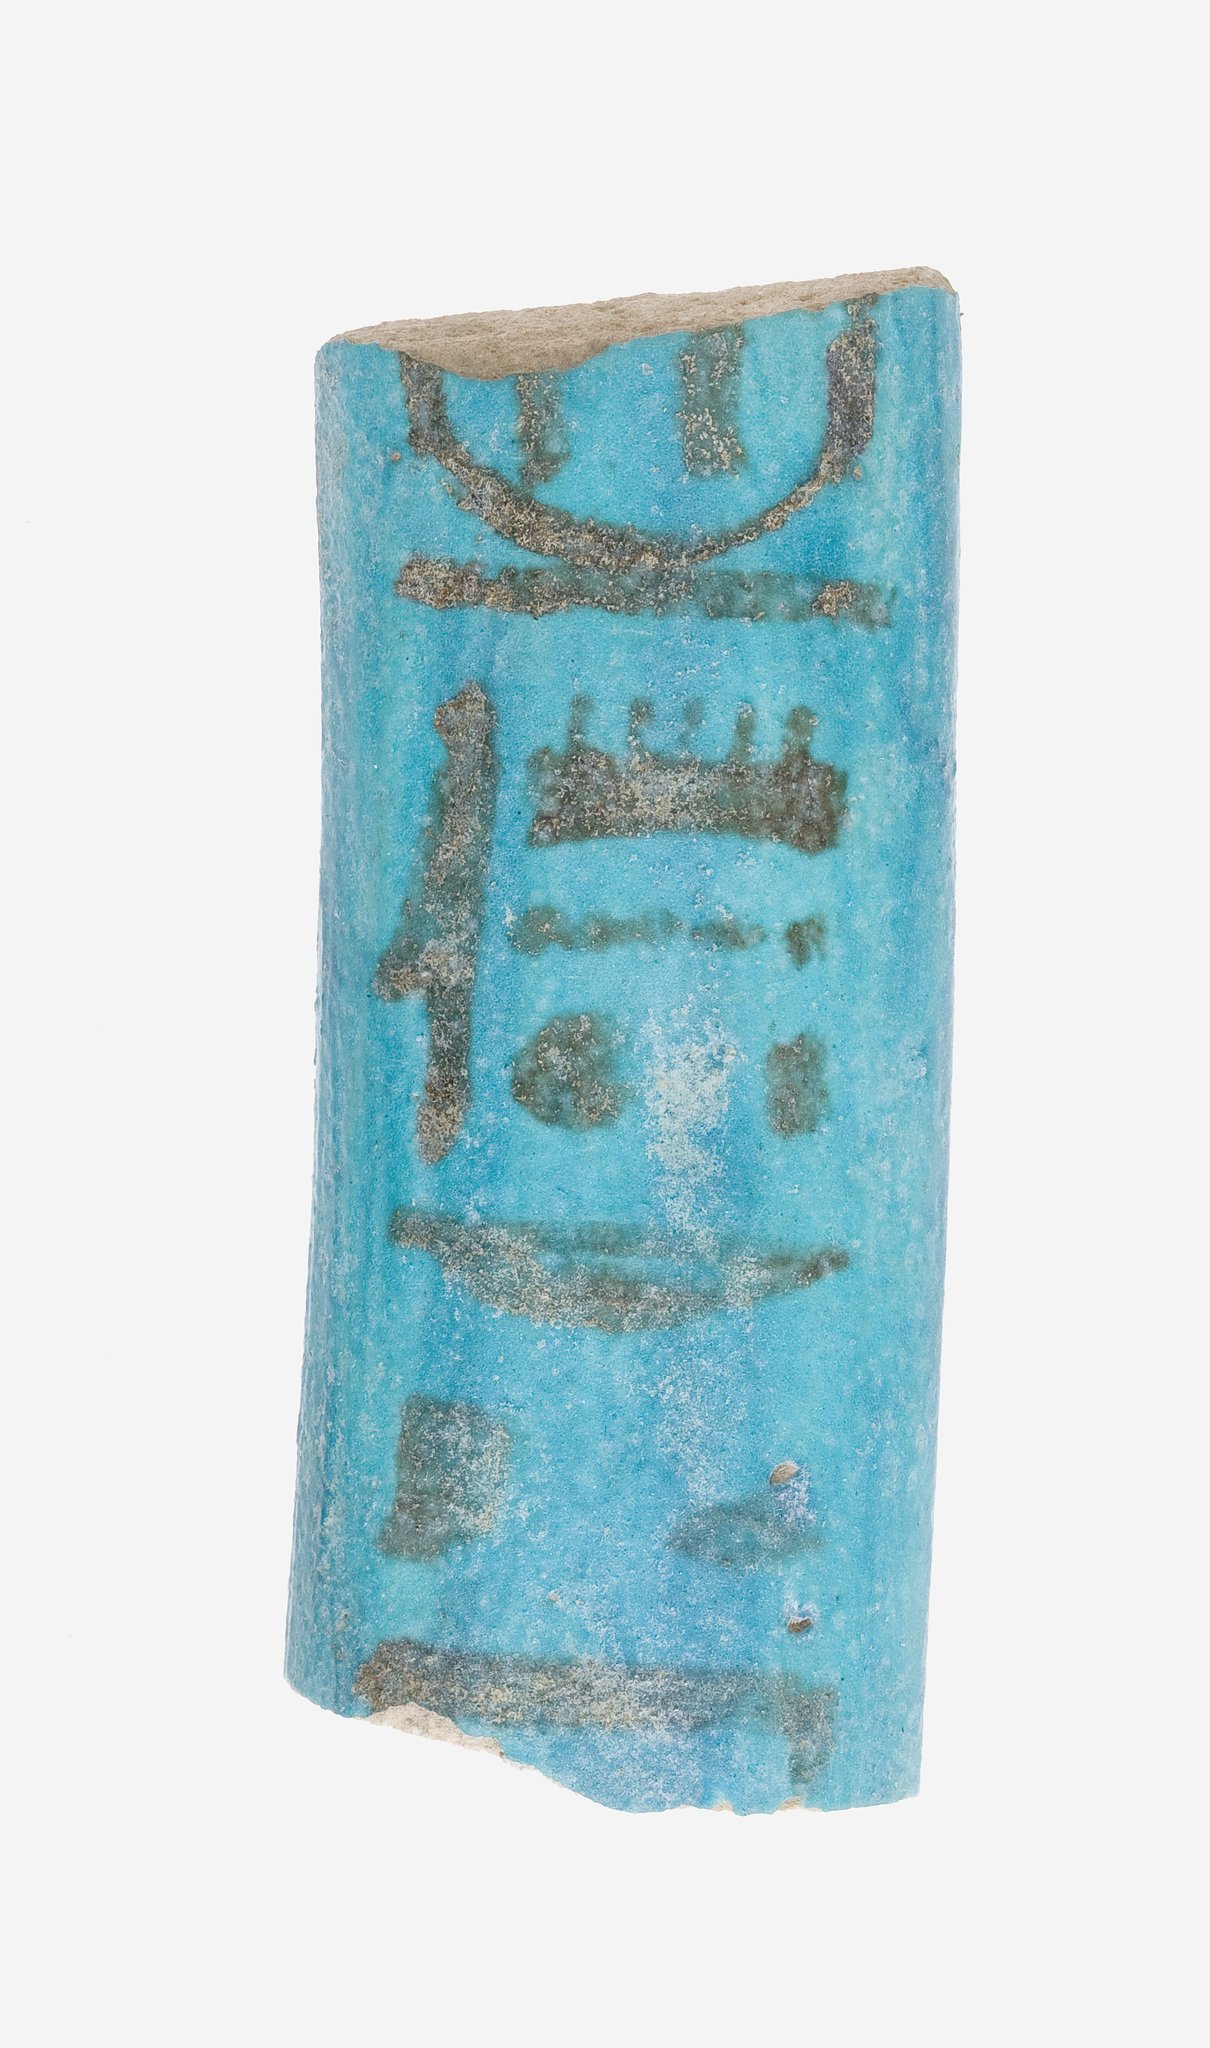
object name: model throw stick fragment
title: Fragment of Throwstick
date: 1390-1352 BCE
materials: faience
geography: egypt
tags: hieroglyphs